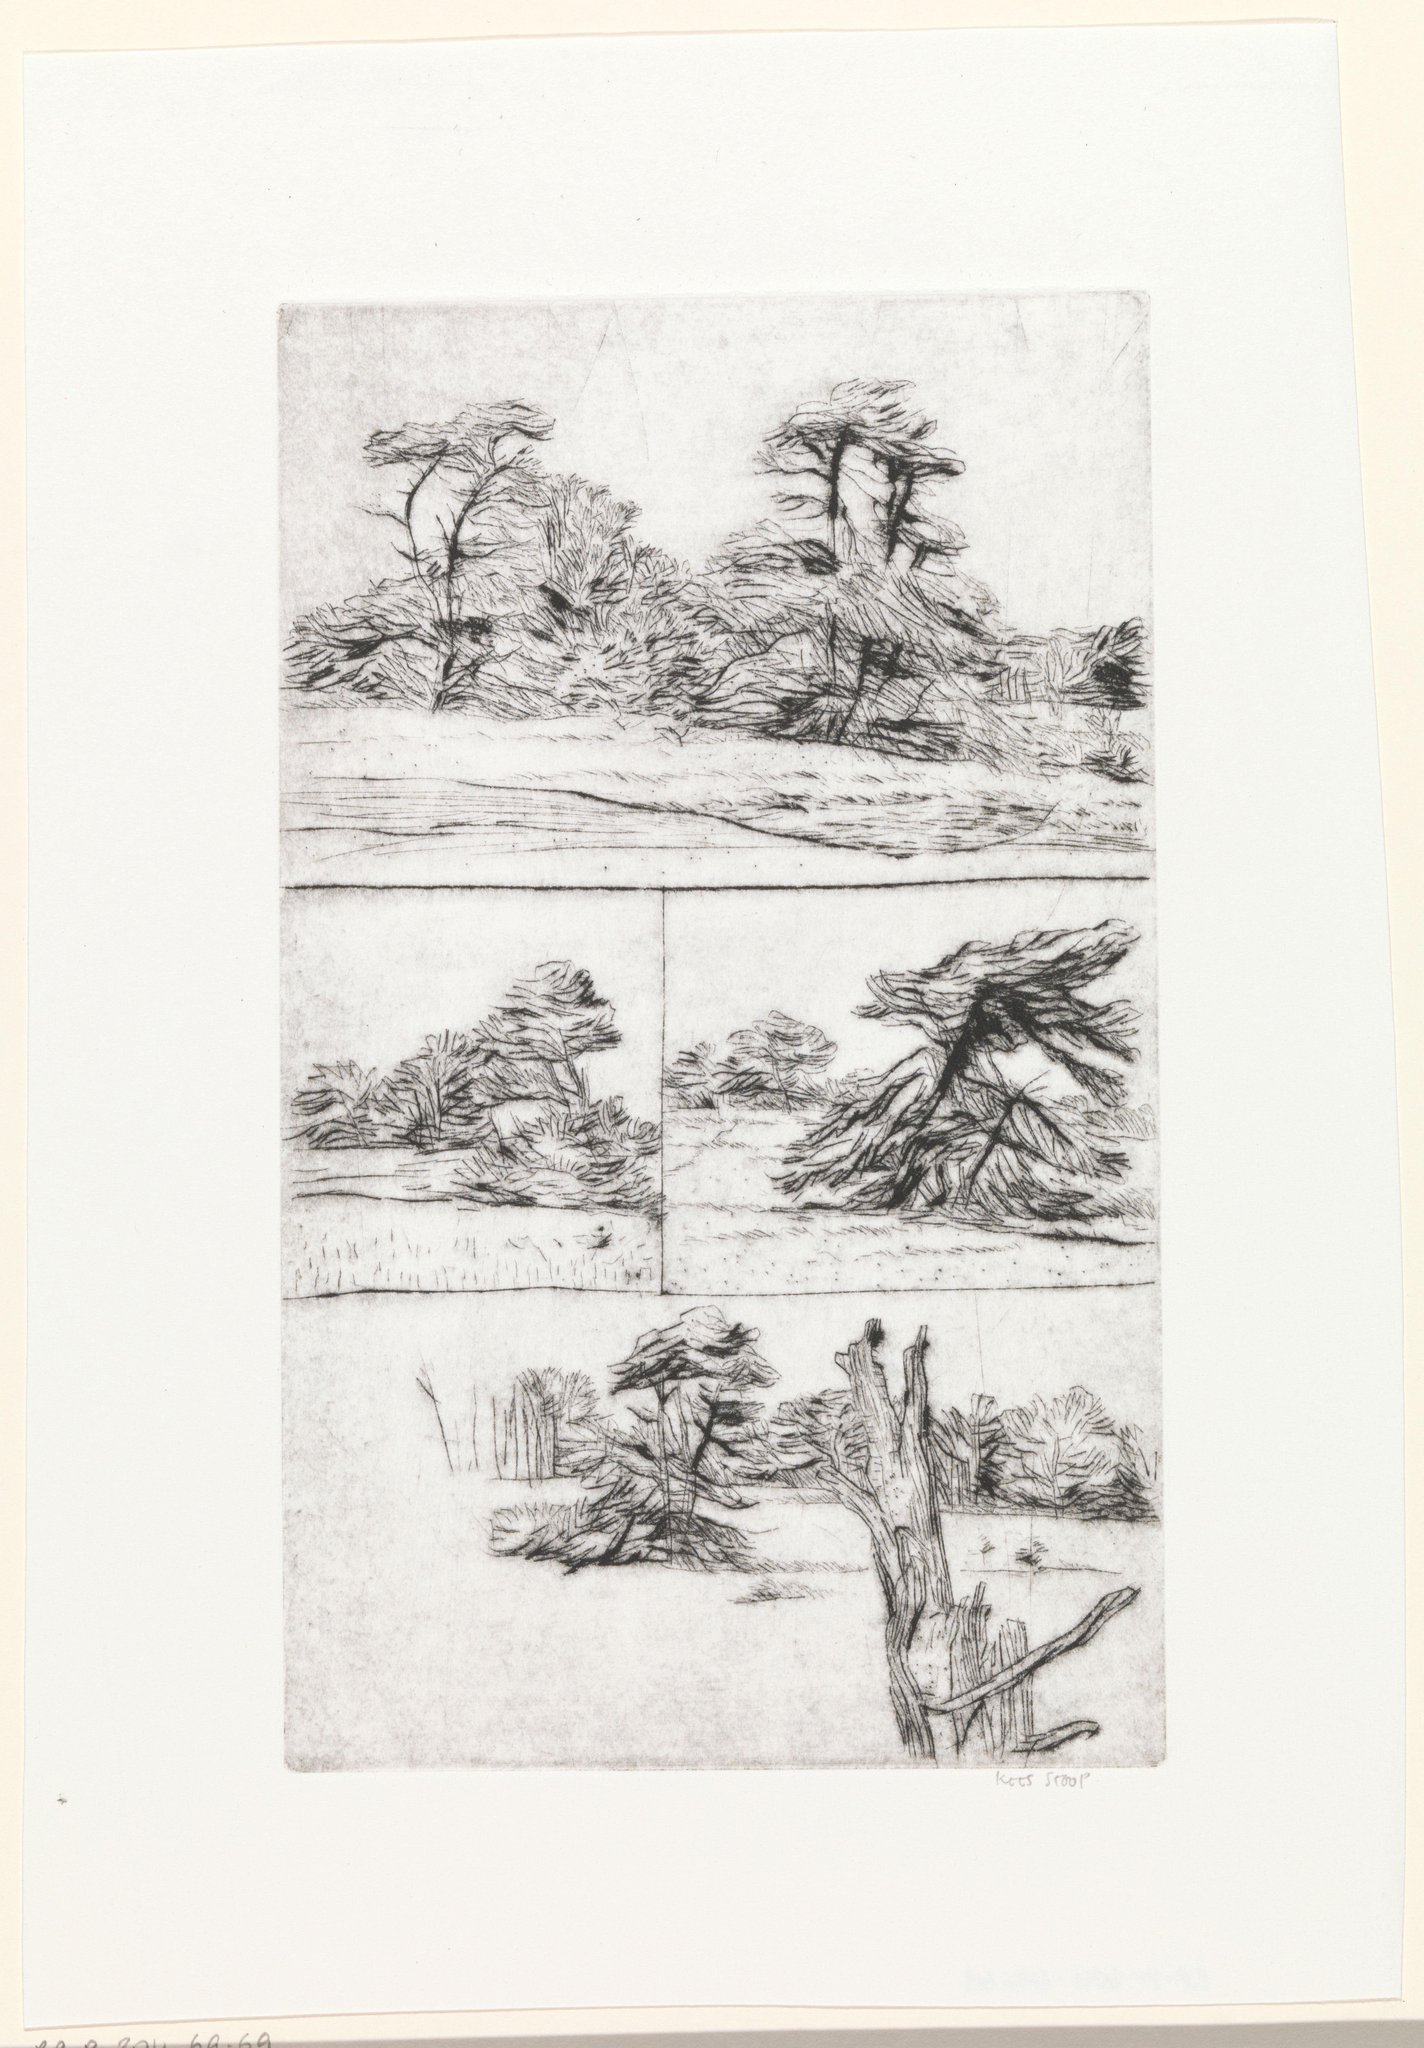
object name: print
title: Dennen op zandvlakte (studie)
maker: kees stoop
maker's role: draughtsman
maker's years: 1929-2019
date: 1944-1990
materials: paper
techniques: drypoint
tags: trees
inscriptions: signature: ‘KEES STOOP’